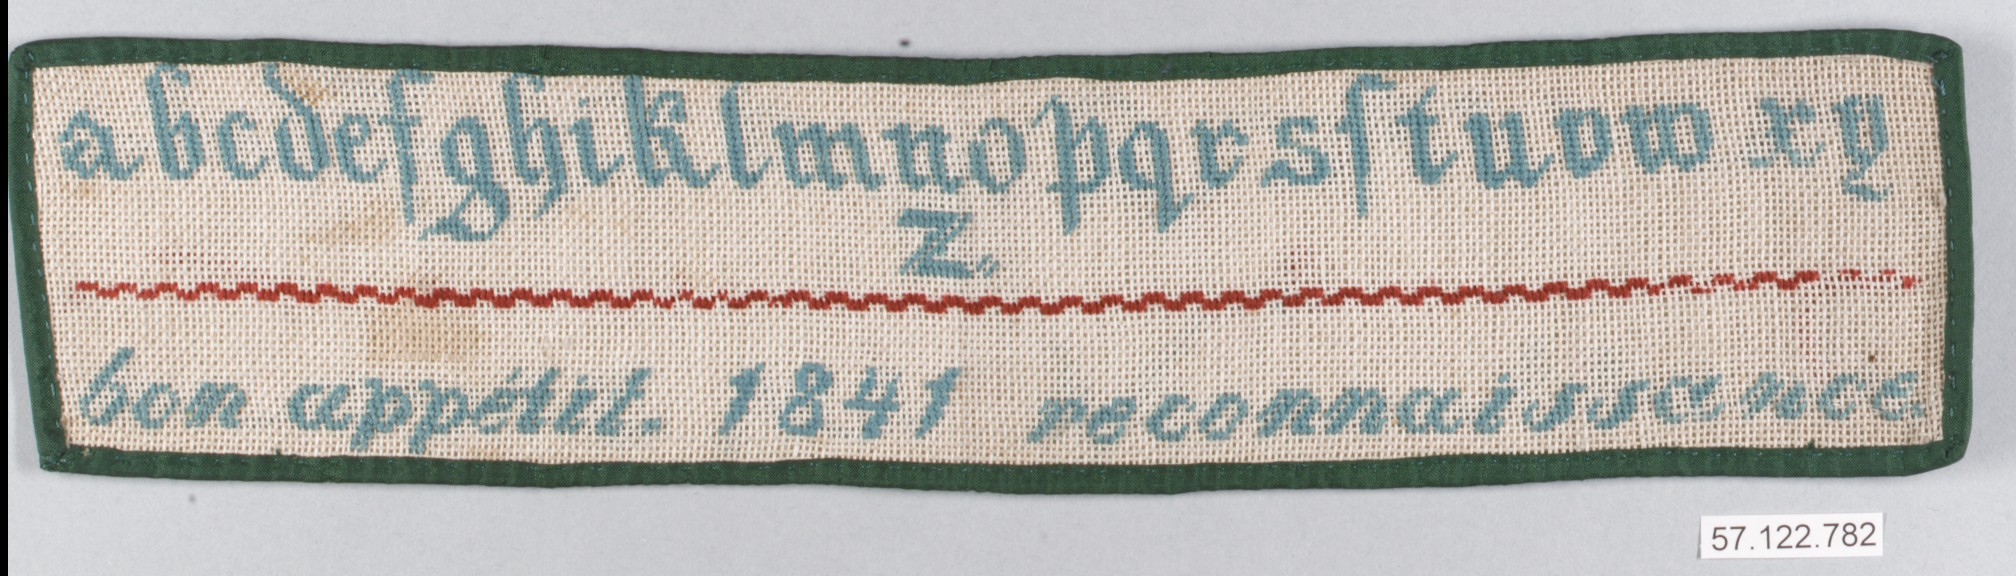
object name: sampler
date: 1841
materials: canvas, wool